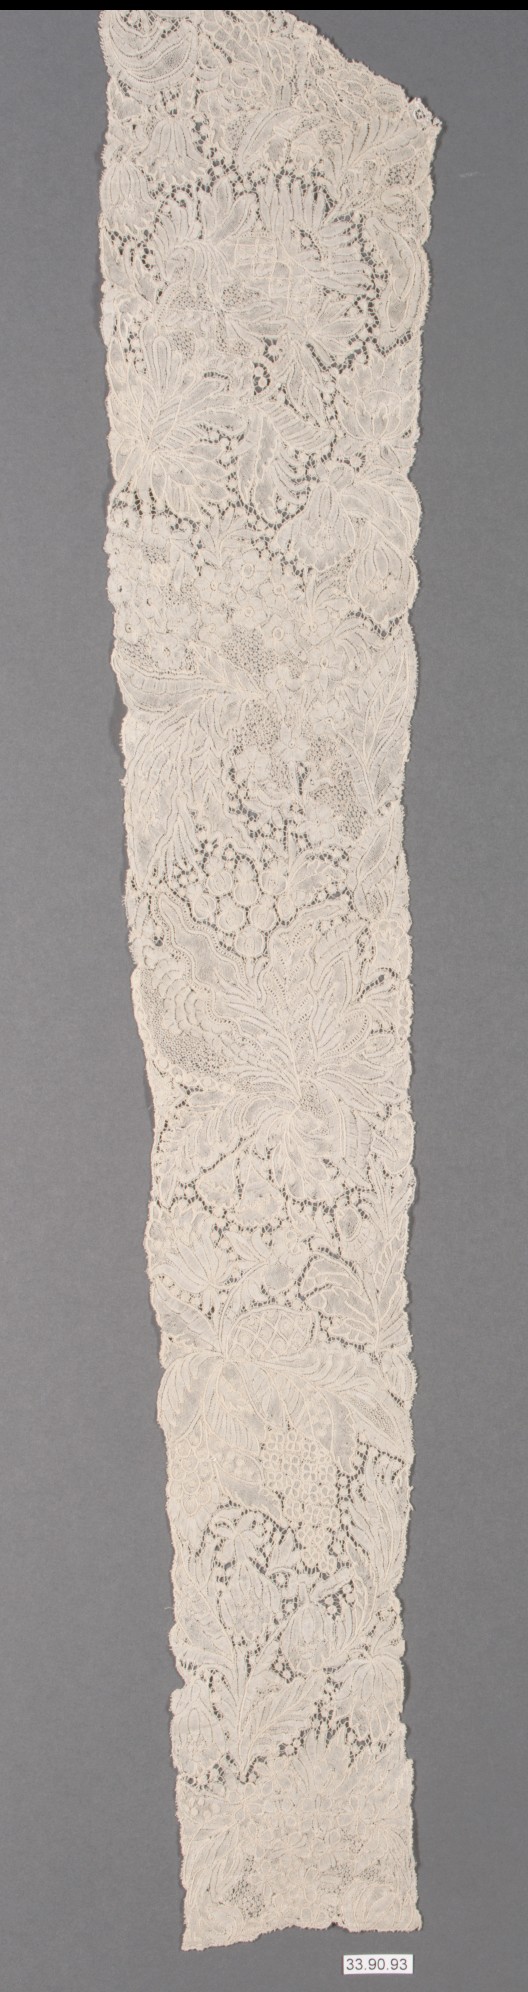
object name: lappet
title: Lappet (one of a pair)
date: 1701-1733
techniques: lace